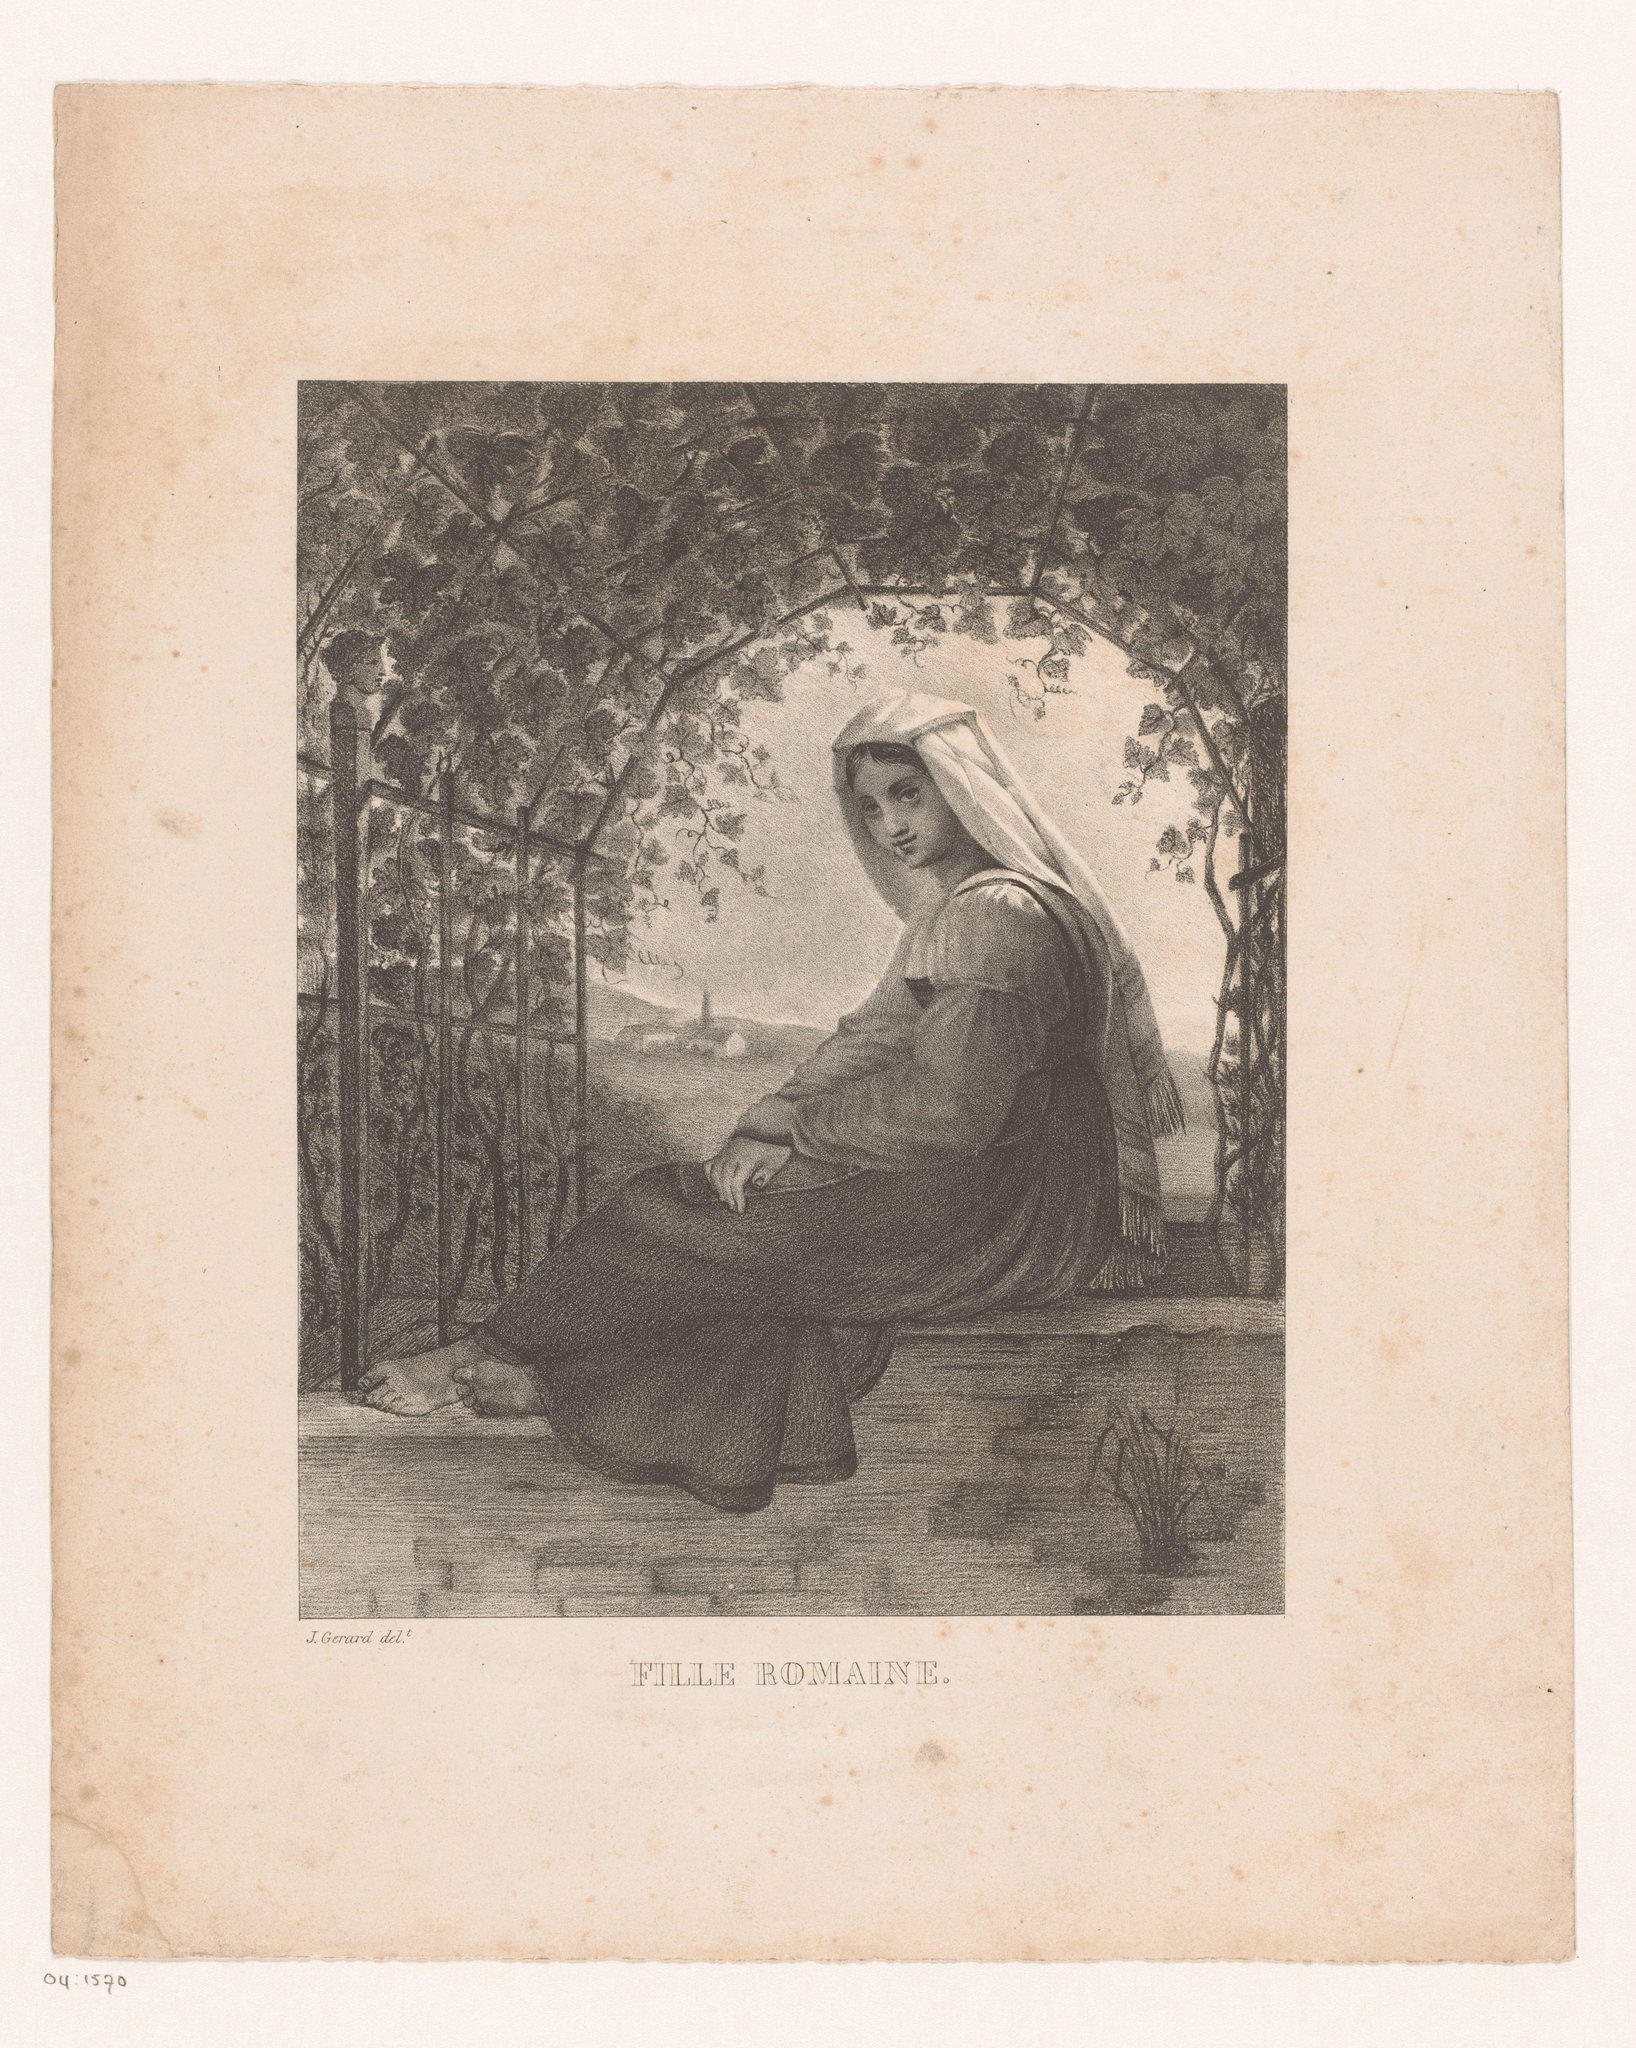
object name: print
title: Fille Romaine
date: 1831-1895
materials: paper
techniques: lithograph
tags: adolescent, young woman, maiden, garden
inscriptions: collector's mark: Lugt 2228